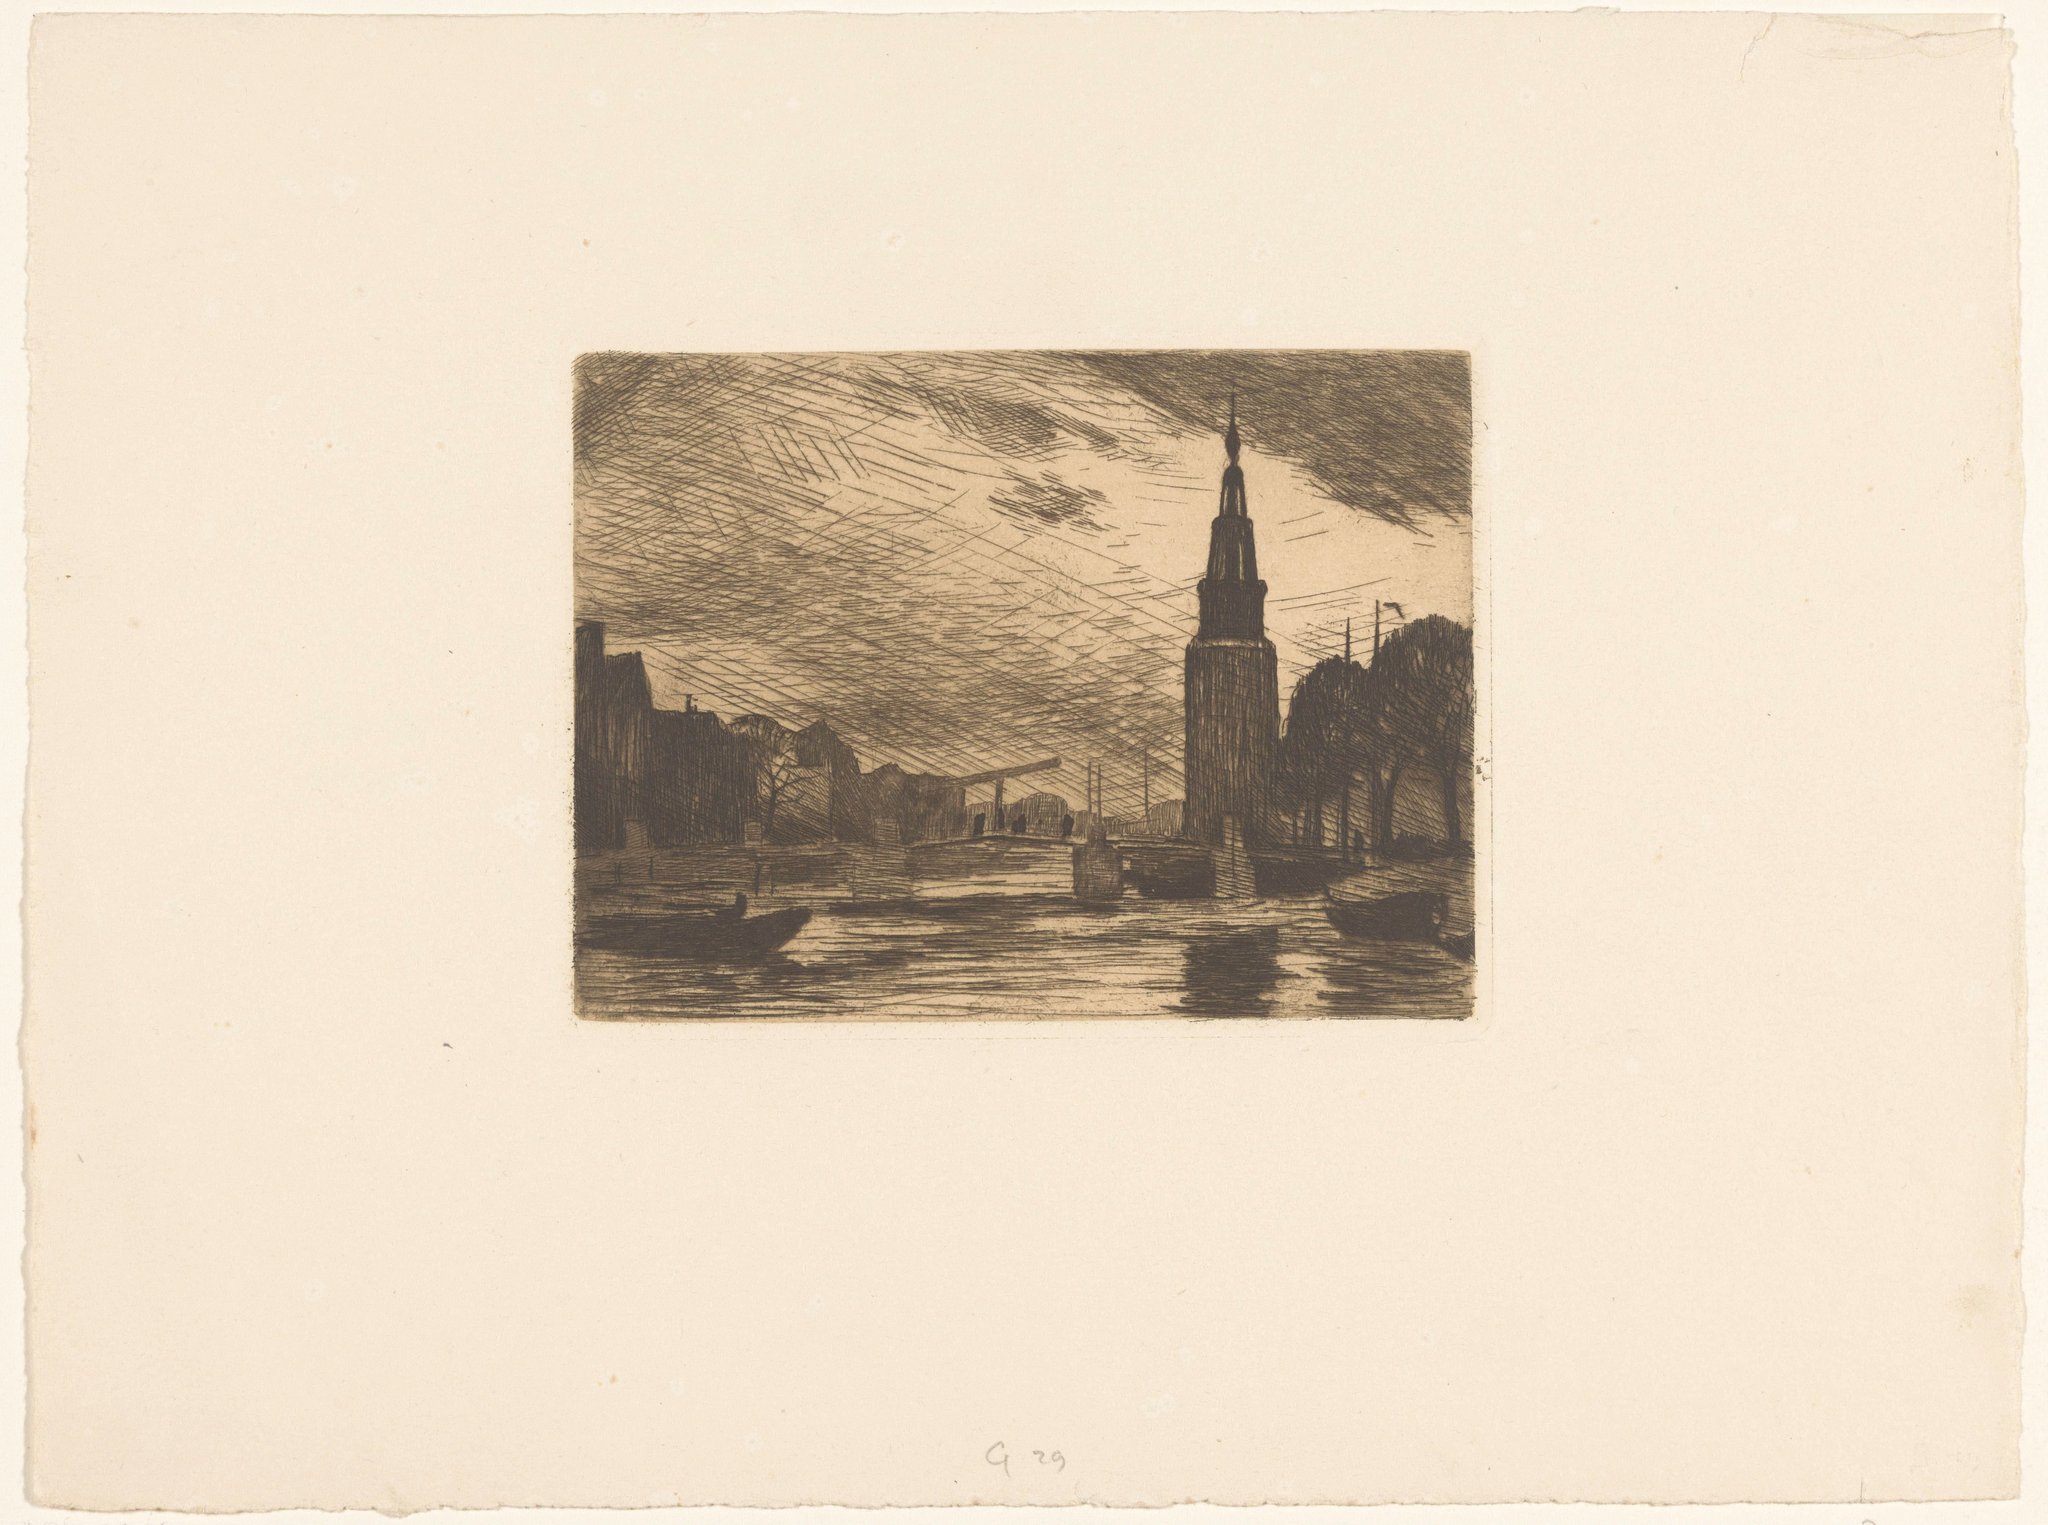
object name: print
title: Oude Schans en de Montelbaanstoren in Amsterdam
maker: willem witsen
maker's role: draughtsman, painter, print maker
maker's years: 1860-1923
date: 1909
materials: paper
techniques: etching, intaglio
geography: amsterdam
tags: city-view, and landscape with man-made constructions, tower, clock tower ~ monumental adornment, canals, waters (in city)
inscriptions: watermark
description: Verschenen als frontispice in de catalogus Etsen en aquarellen W. Witsen, uitgegeven ter gelegenheid van een tentoonstelling bij Van Wisselingh in maart-april 1909.